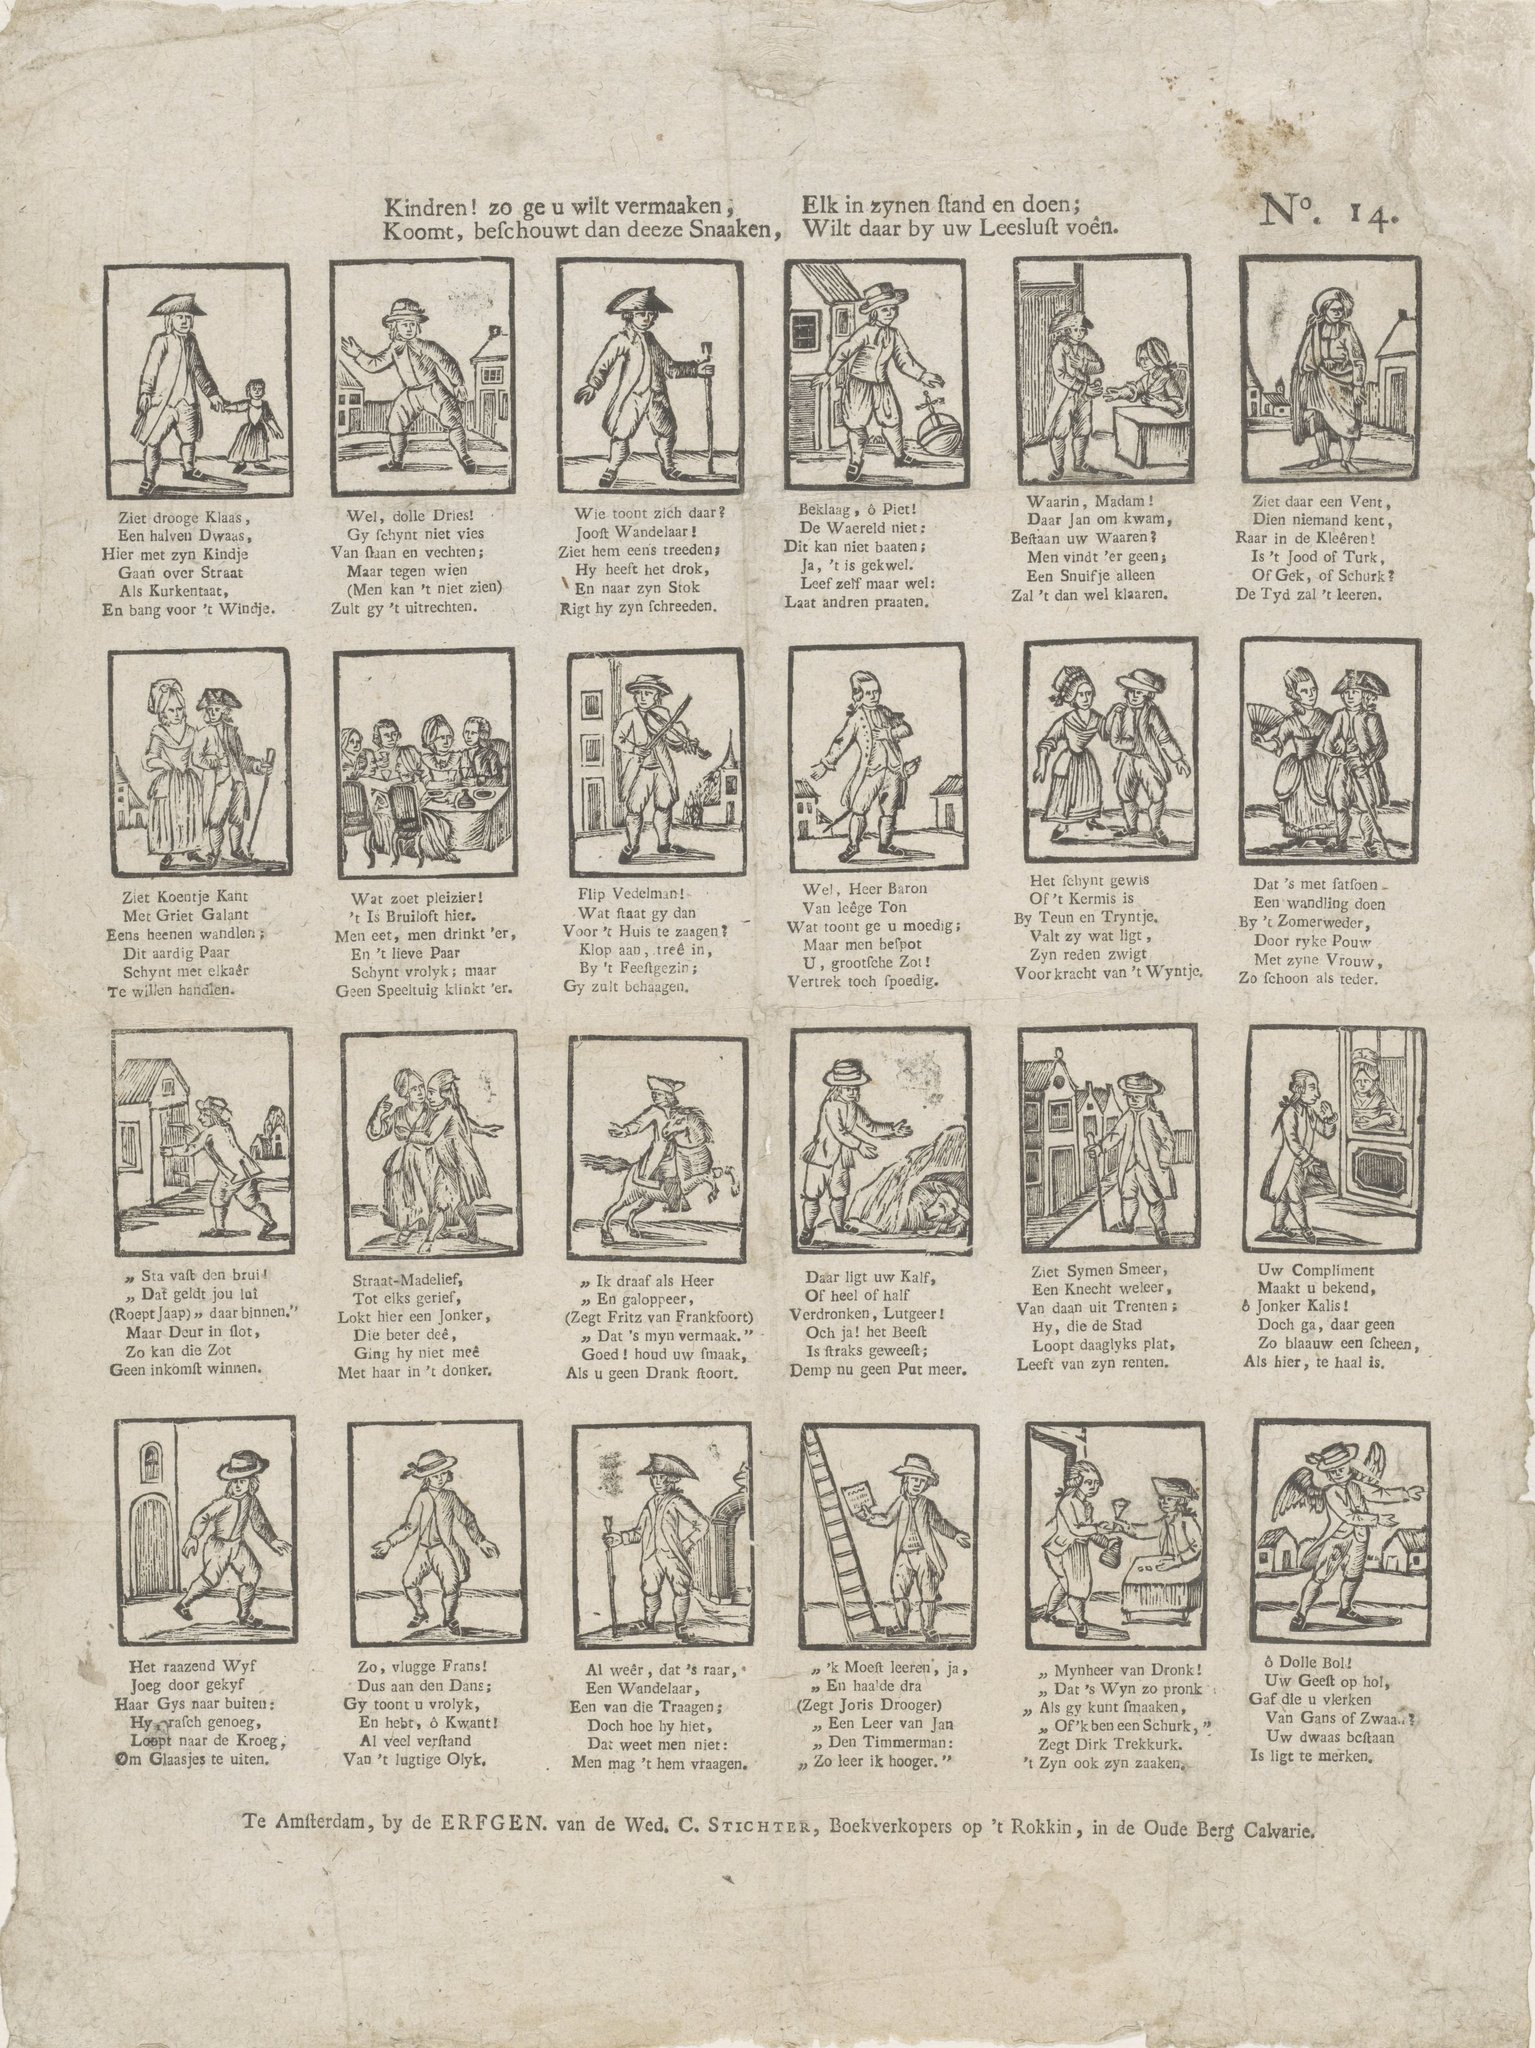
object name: print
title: Kindren! zo ge u wilt vermaaken, / Koomt, beschouwt dan deeze snaaken, / Elk in zynen stand en doen; / Wilt daar by uw leeslust voên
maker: Anonymous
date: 1715-1813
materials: paper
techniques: letterpress printing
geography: netherlands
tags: human types, characters (human types)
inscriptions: collector's mark: Lugt 2760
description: Blad met 24 voorstellingen van verschillende figuren. Onder elke afbeelding een zesregelig vers. Genummerd rechtsboven: No. 14.